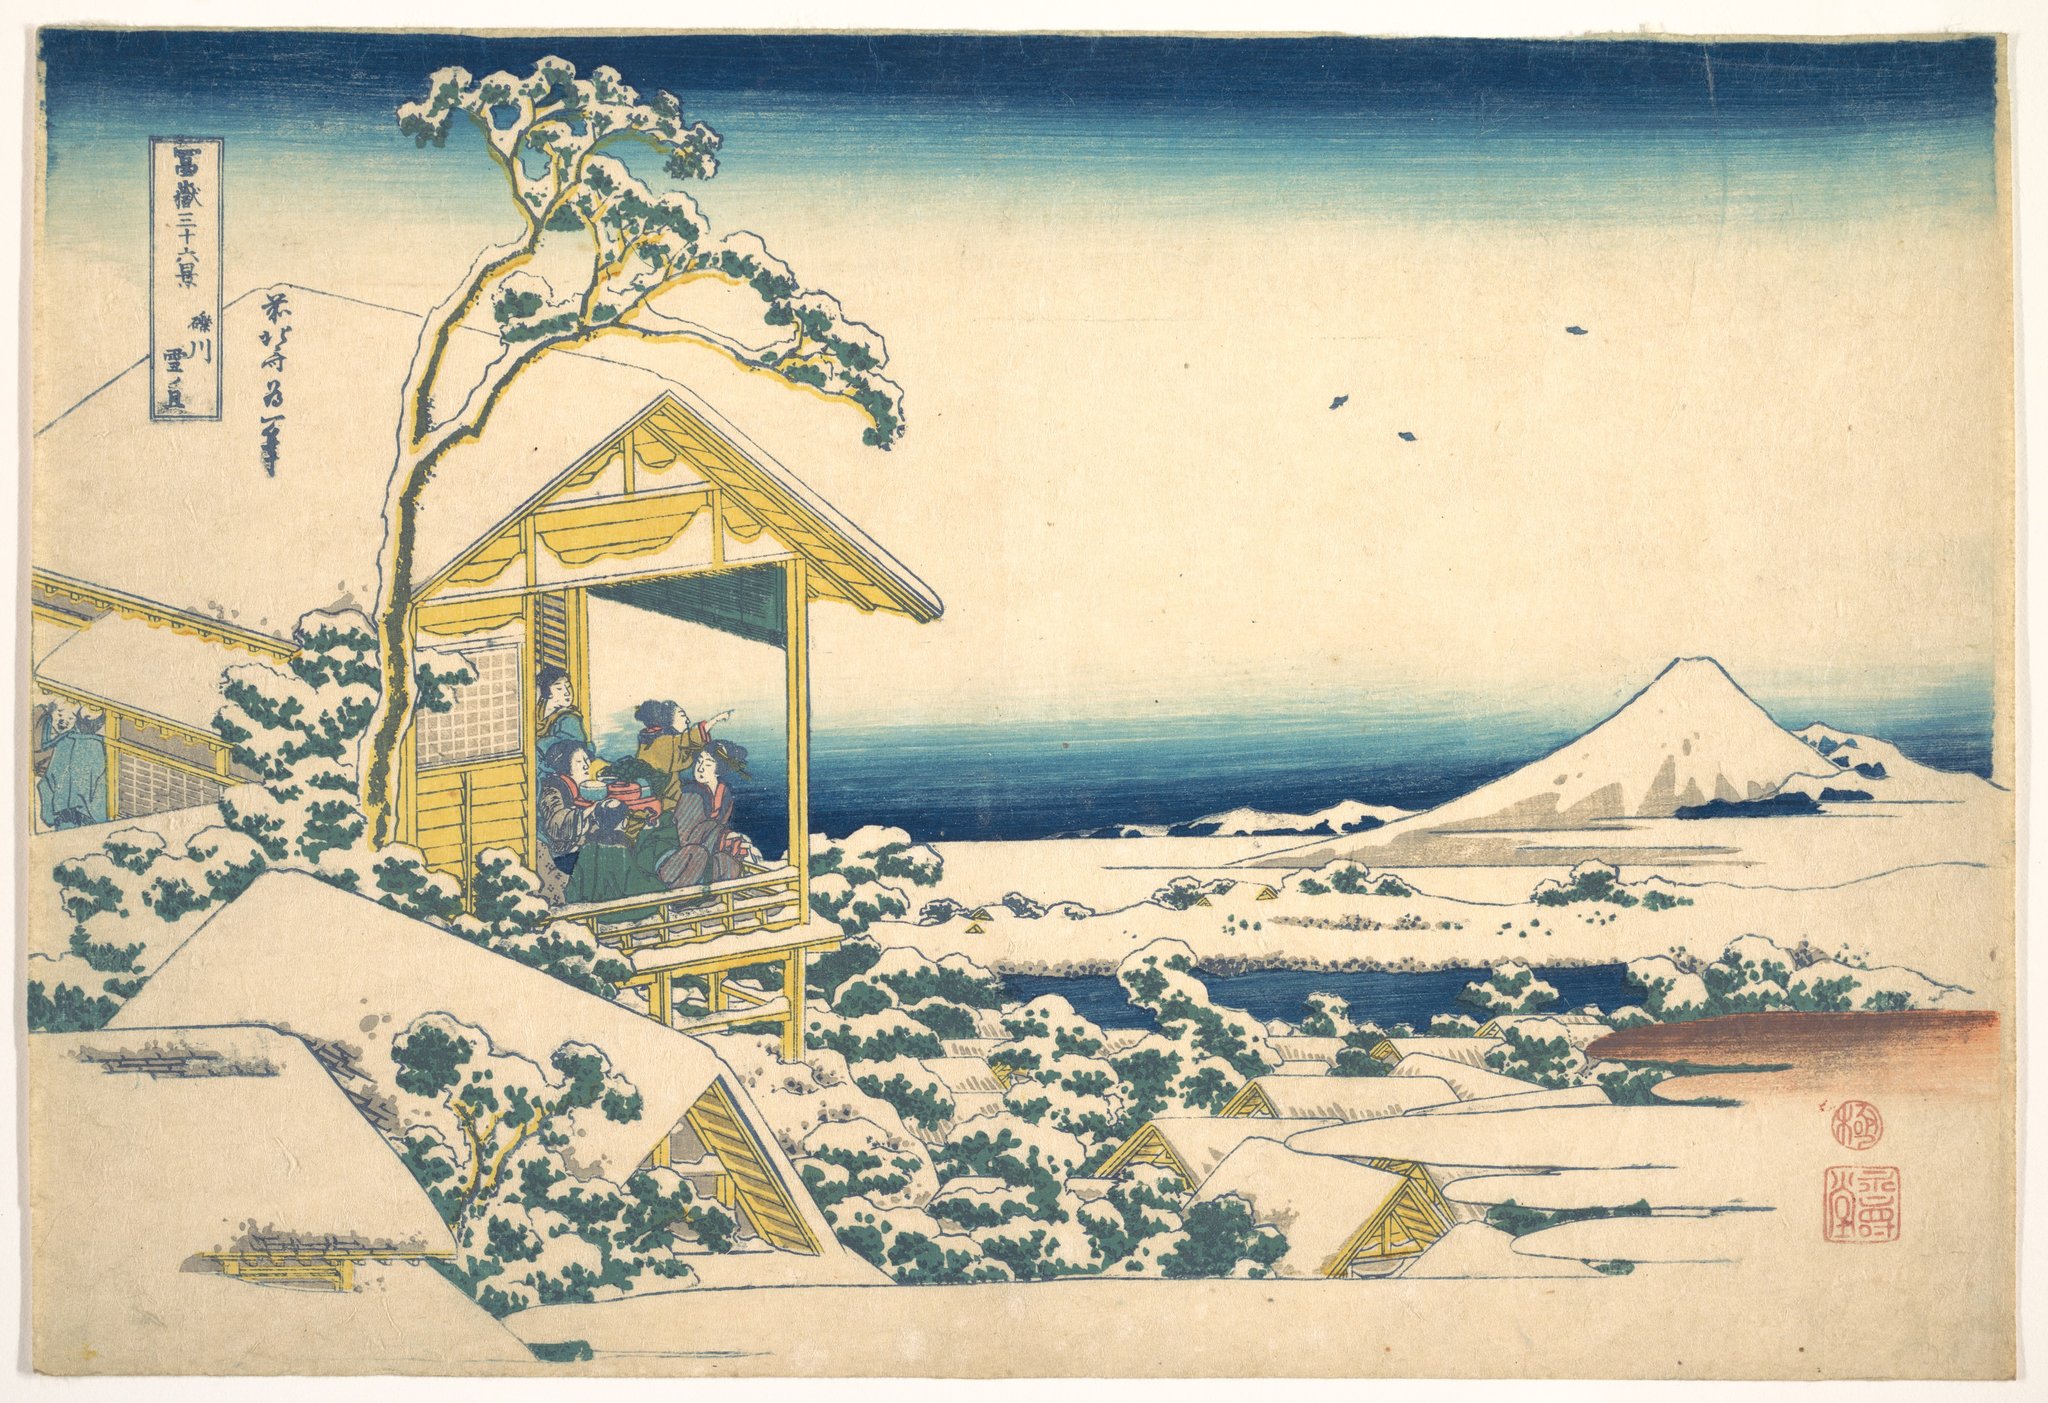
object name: woodblock print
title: Morning after the Snow at Koishikawa in Edo (Koishikawa yuki no ashita), from the series Thirty-six Views of Mount Fuji (Fugaku sanjūrokkei)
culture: japanese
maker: katsushika hokusai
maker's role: artist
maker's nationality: japanese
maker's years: 1760-1849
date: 1830-1832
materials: ink, paper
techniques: woodblock print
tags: mountains,snow,tea houses